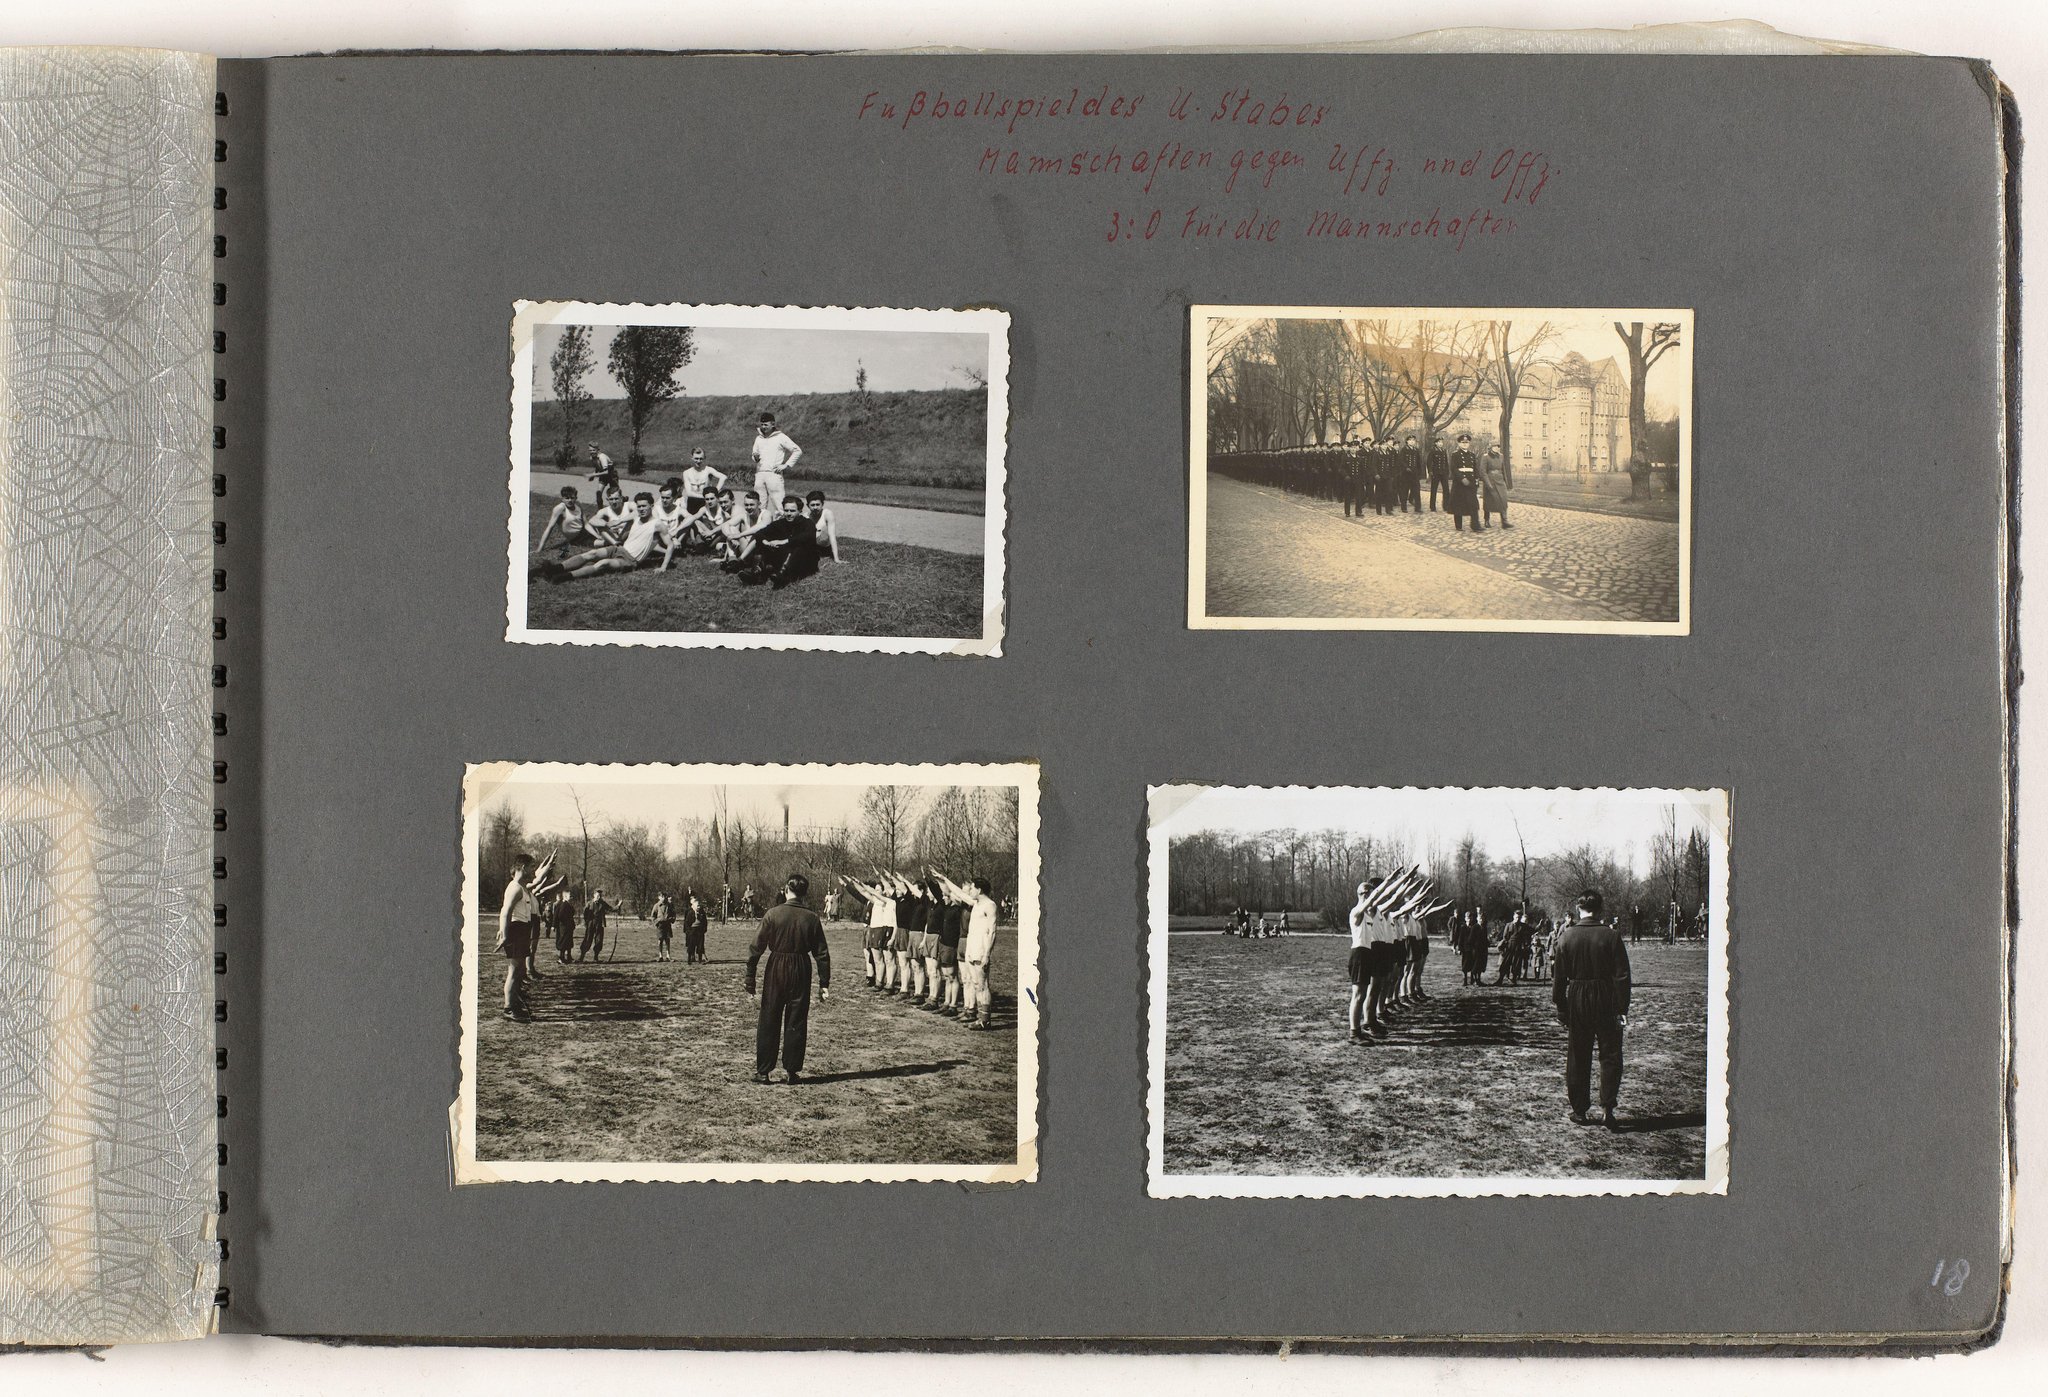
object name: photograph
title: Voetbal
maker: Anonymous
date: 1941-1945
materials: paper, photographic support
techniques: gelatin silver print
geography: netherlands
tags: the company, the unit, the troop ~ military service, soccer, football (early names: soule, choule, cholle), netherlands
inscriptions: inscription: ‘Fußballspiel des U. Stabes / Mannschaften gegen Uffz. und Offz. / 3: 0 Für die Mannschaften’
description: Albumblad met vier foto's, waarvan drie van een voetbalwedstrijd van de manschappen tegen de officieren. Voor en na het spel werd de Hitlergroet gebracht.